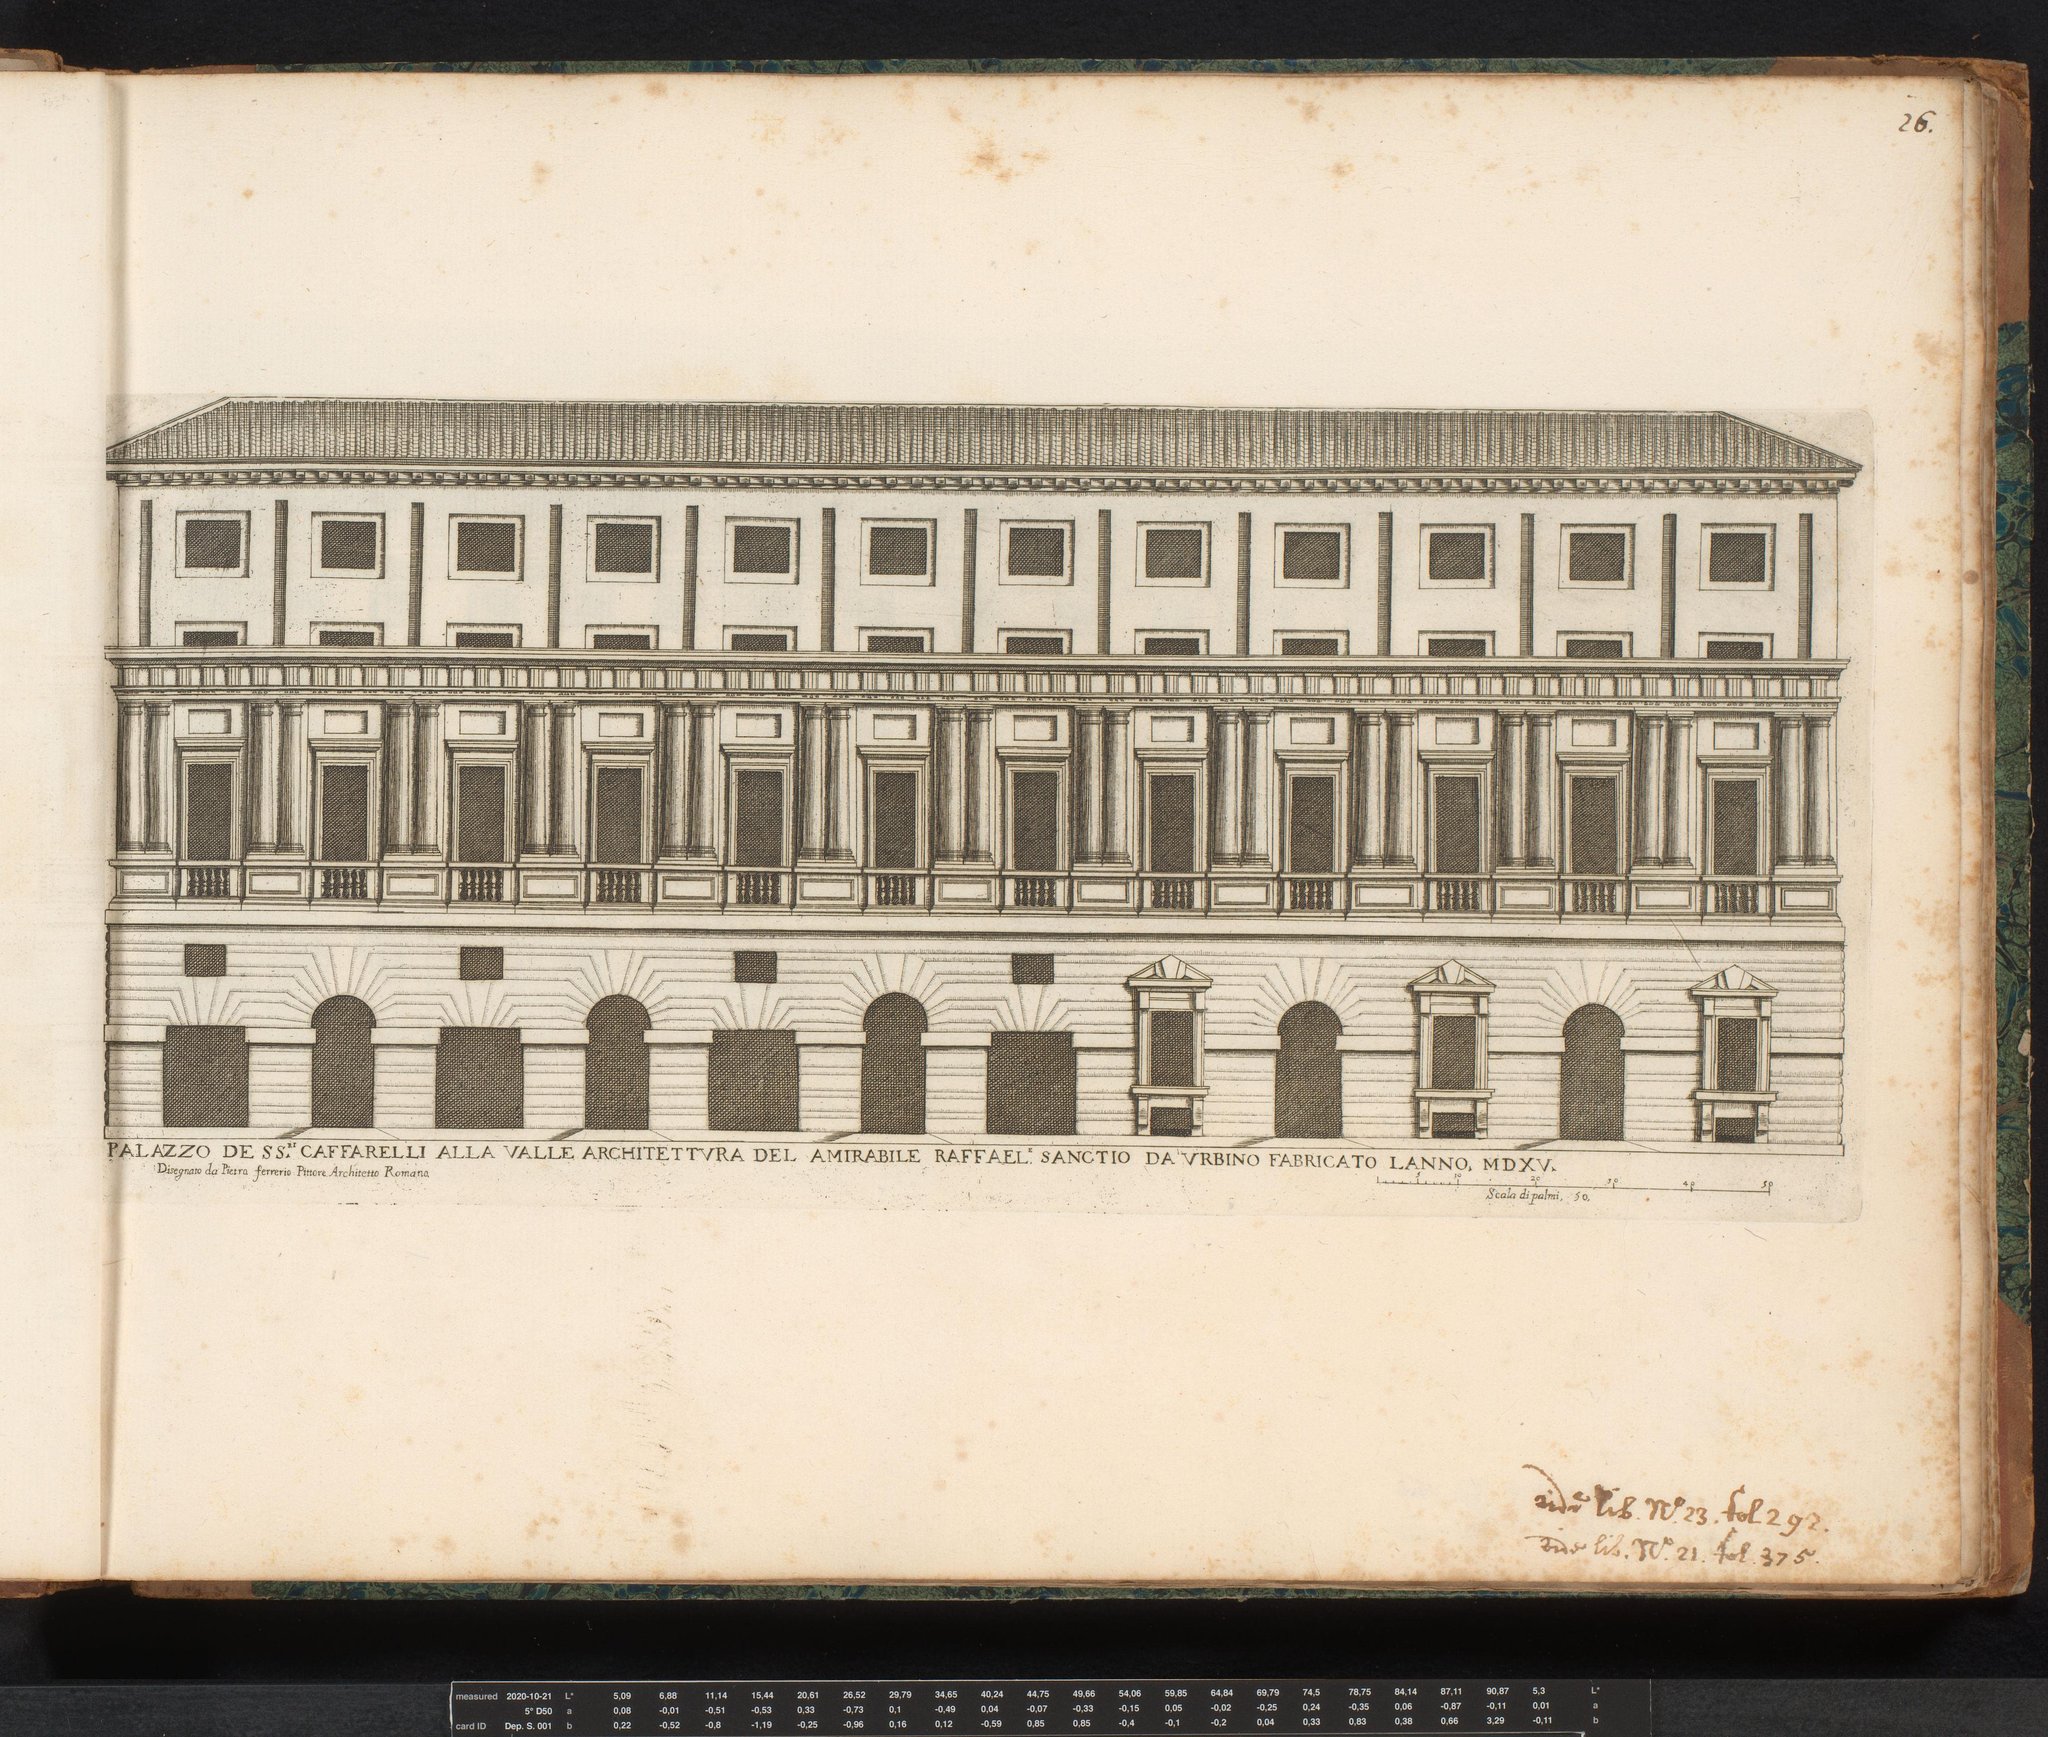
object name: print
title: Palazzi di Roma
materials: paper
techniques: etching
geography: italy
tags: palace, façade (of house or building)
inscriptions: inscription: ‘Ende lib. No. 23. fol. 292./ Ende lib. No. 21. fol. 375.’, number: ‘26’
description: Deze prent maakt deel uit van de reeks getiteld: Palazzi di Roma. Deze reeks bestaat uit twee boeken. Boek één getiteld: Palazzi di Roma dei più celebri architetti..., bestaat uit 44 prenten die worden toegeschreven aan Giovanni Battista Falda (naam staat enkel op prent 27) en uitgegeven door Giovanni Giacomo de'Rossi. Deze 44 prenten zijn bekend in twee staten (met en zonder nummer). Boek twee getiteld: Nuovi disegni dell'architetture... libro secondo, bevat 66 prenten door Giovanni Battista Falda en Simone Felice. Deze 66 prenten zijn bekend in twee staten (met en zonder nummer).